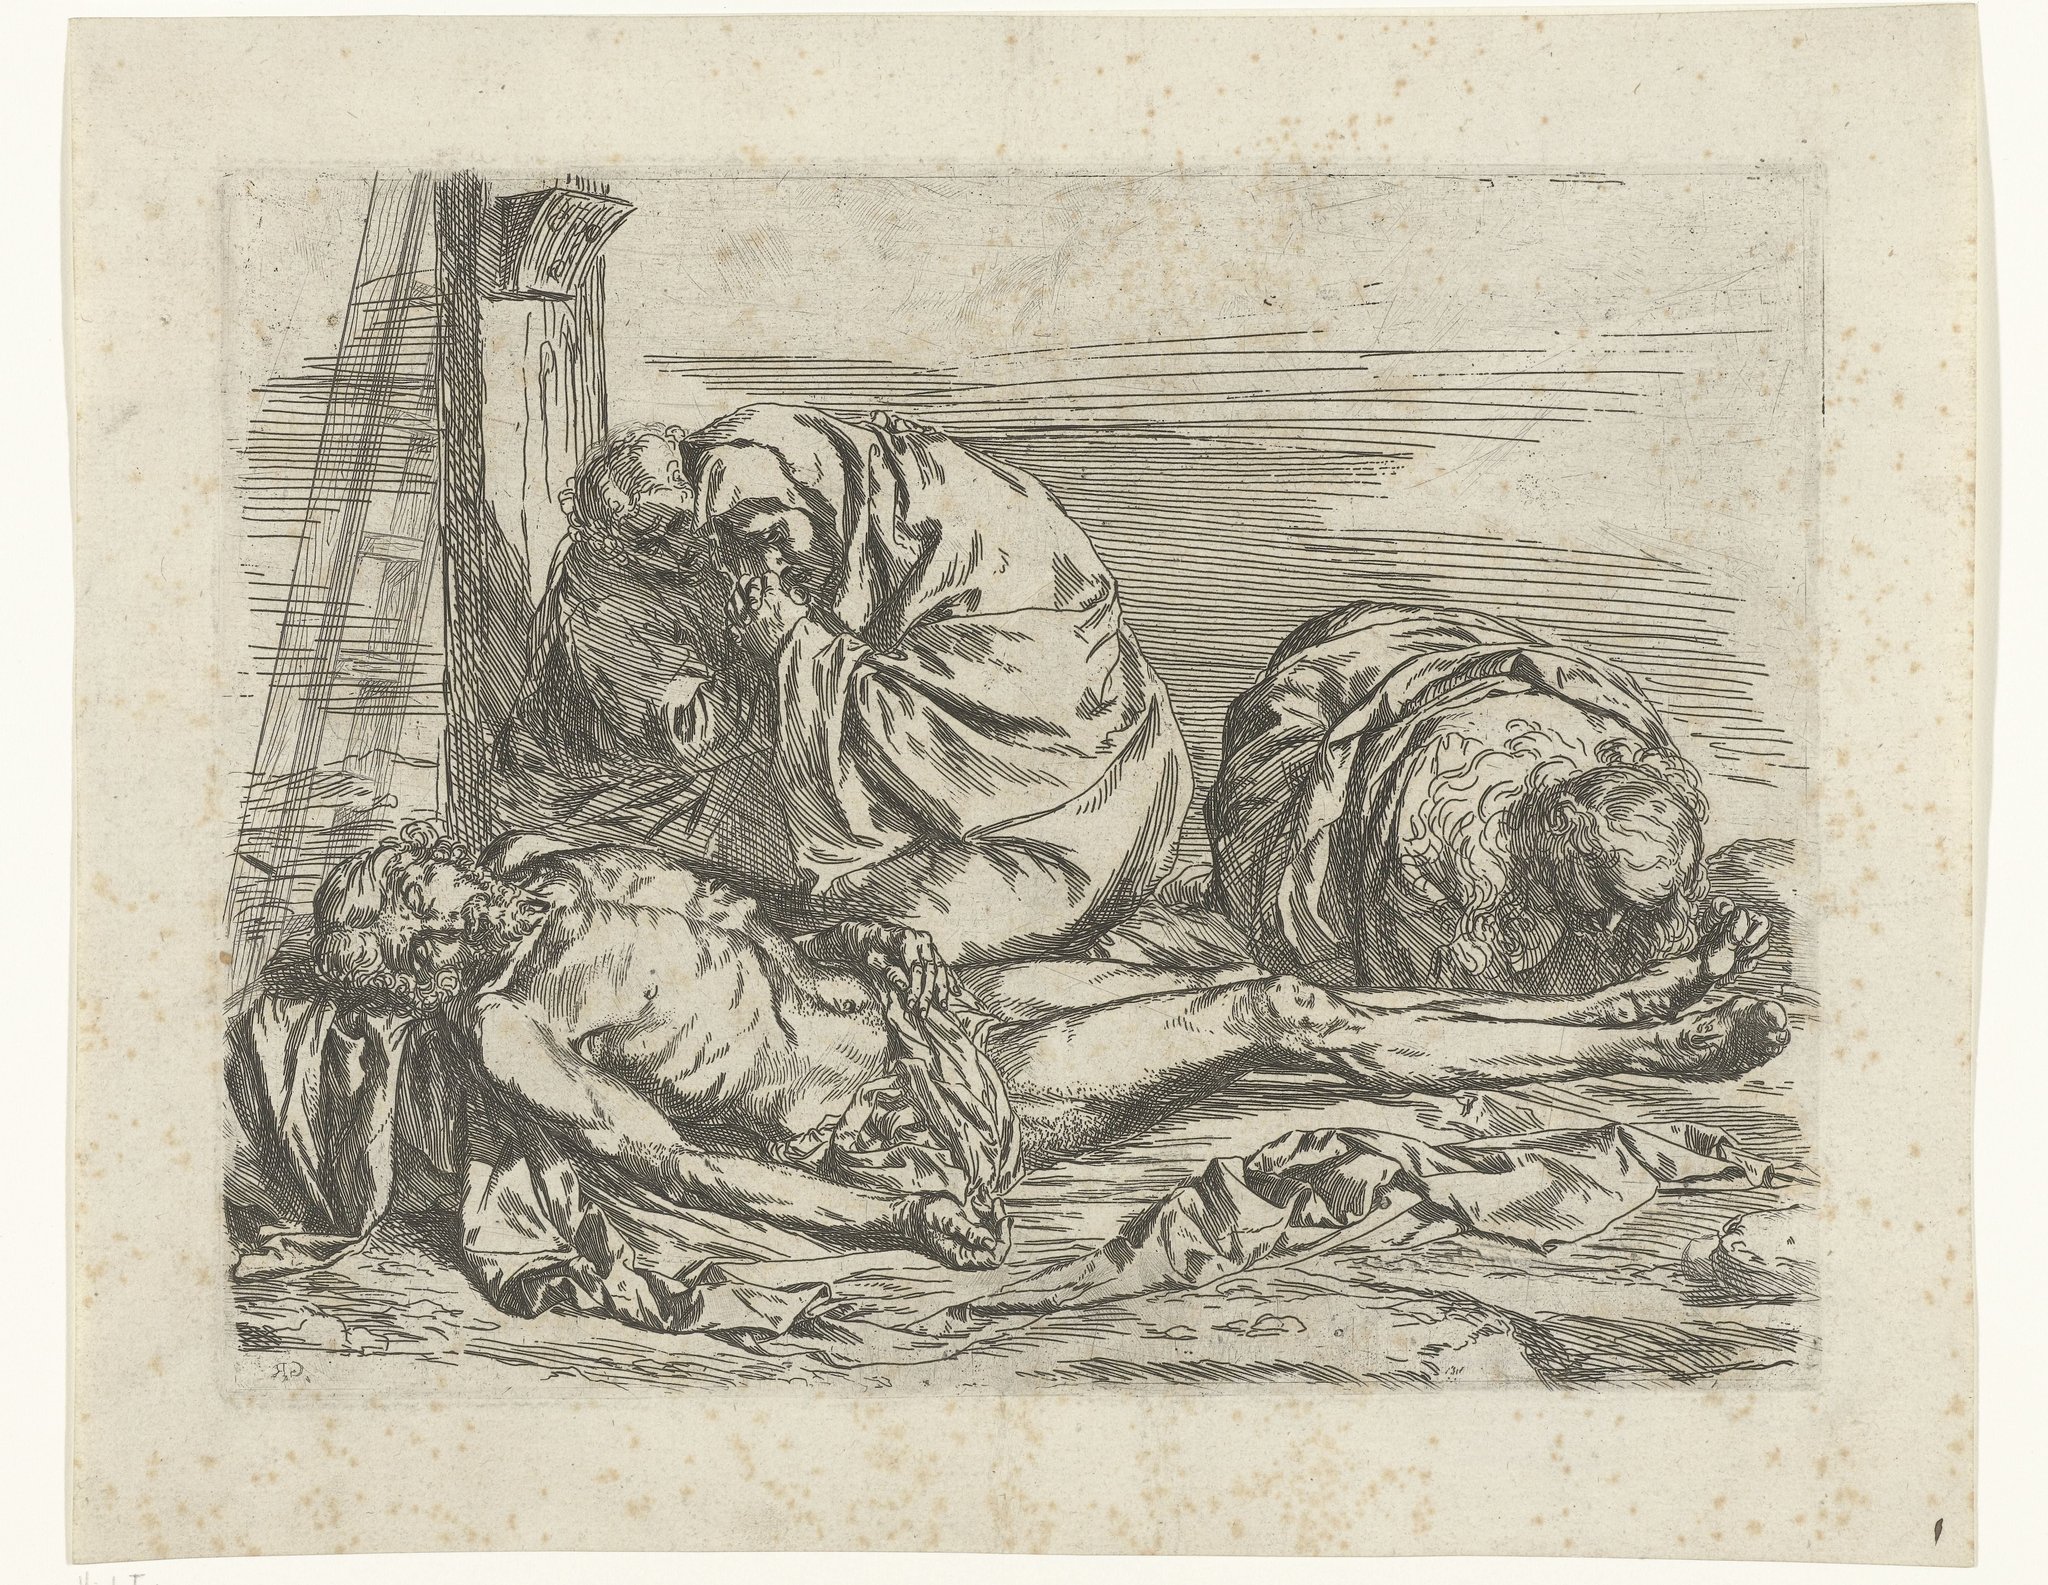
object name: print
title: Bewening van Christus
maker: Anonymous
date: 1600-1624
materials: paper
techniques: etching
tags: christ's body lying on the ground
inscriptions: collector's mark: Lugt 10, collector's mark: Lugt 11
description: Maria, ondersteund door Johannes, en Maria Magdalena knielen bij het lichaam van Christus.